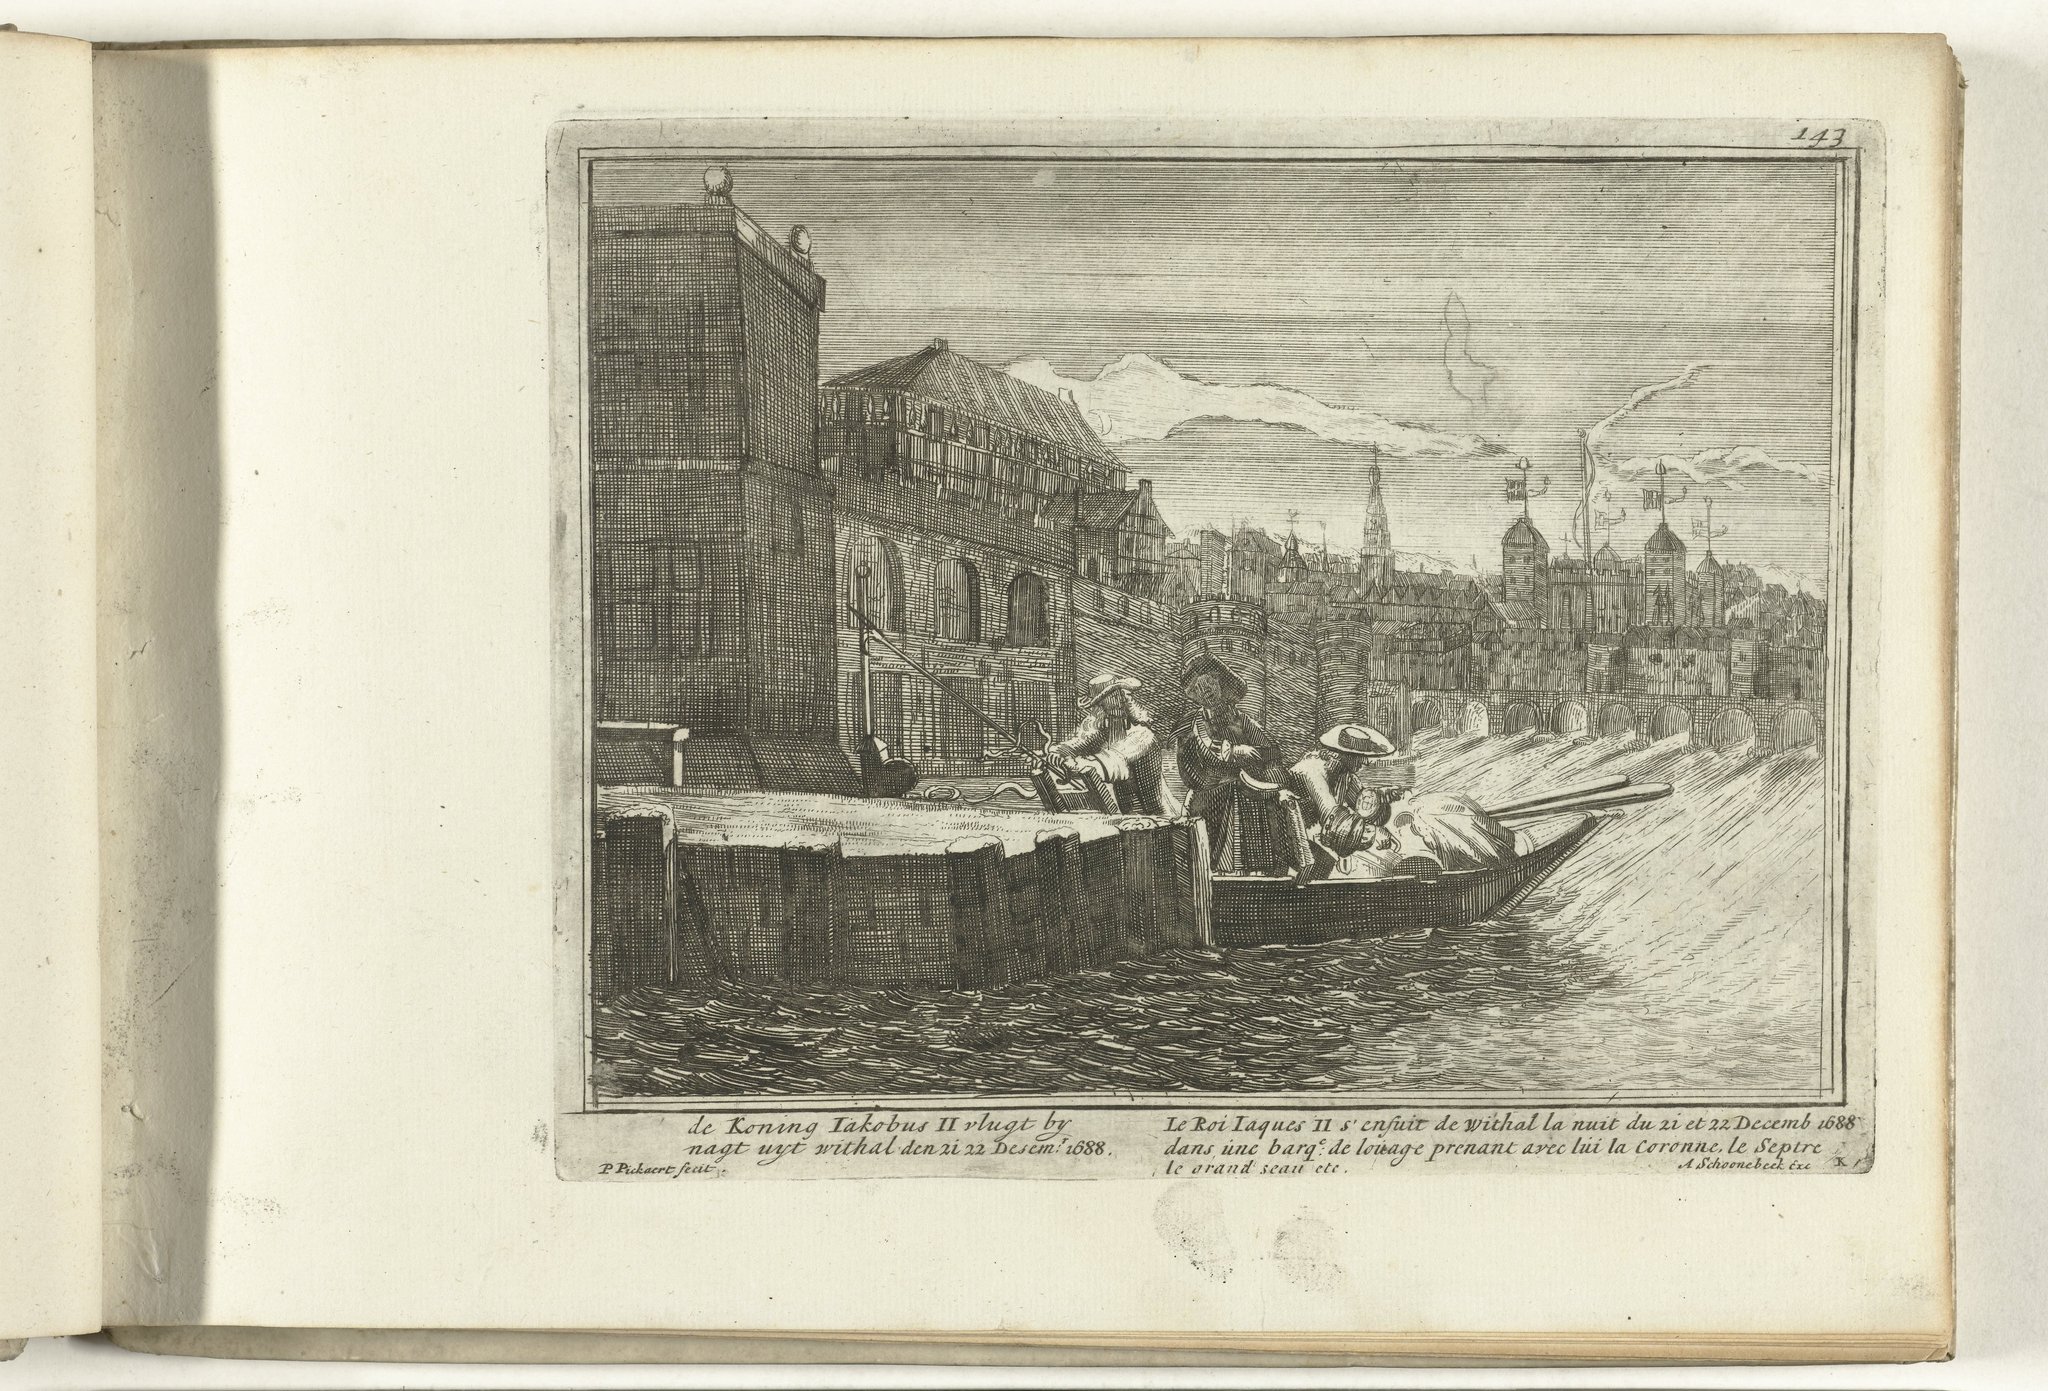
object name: print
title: Engelants schouwtoneel, verbeeldende het vlugte van Jacobus II, Koning van Groot Brittanyen etc. met desselfs aankomst in Yrlant en verdere voorvallen, I Deel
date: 1689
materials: paper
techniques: etching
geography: amsterdam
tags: jacobus ii (koning van engeland en schotland), flight of ruler from adversary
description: De vlucht van koning Jacobus II bij nacht uit het paleis van Whitehall Londen, 20 december 1688. Bezittingen worden in een roeibootje geladen. Genummerd rechtsboven: 143. Plaat K in de serie 'Engelants schouwtoneel' over de Glorious Revolution en gebeurtenissen uit de voorafgaande jaren 1685-1689 (eerste deel). Met onderschriften in het Nederlands en Frans.